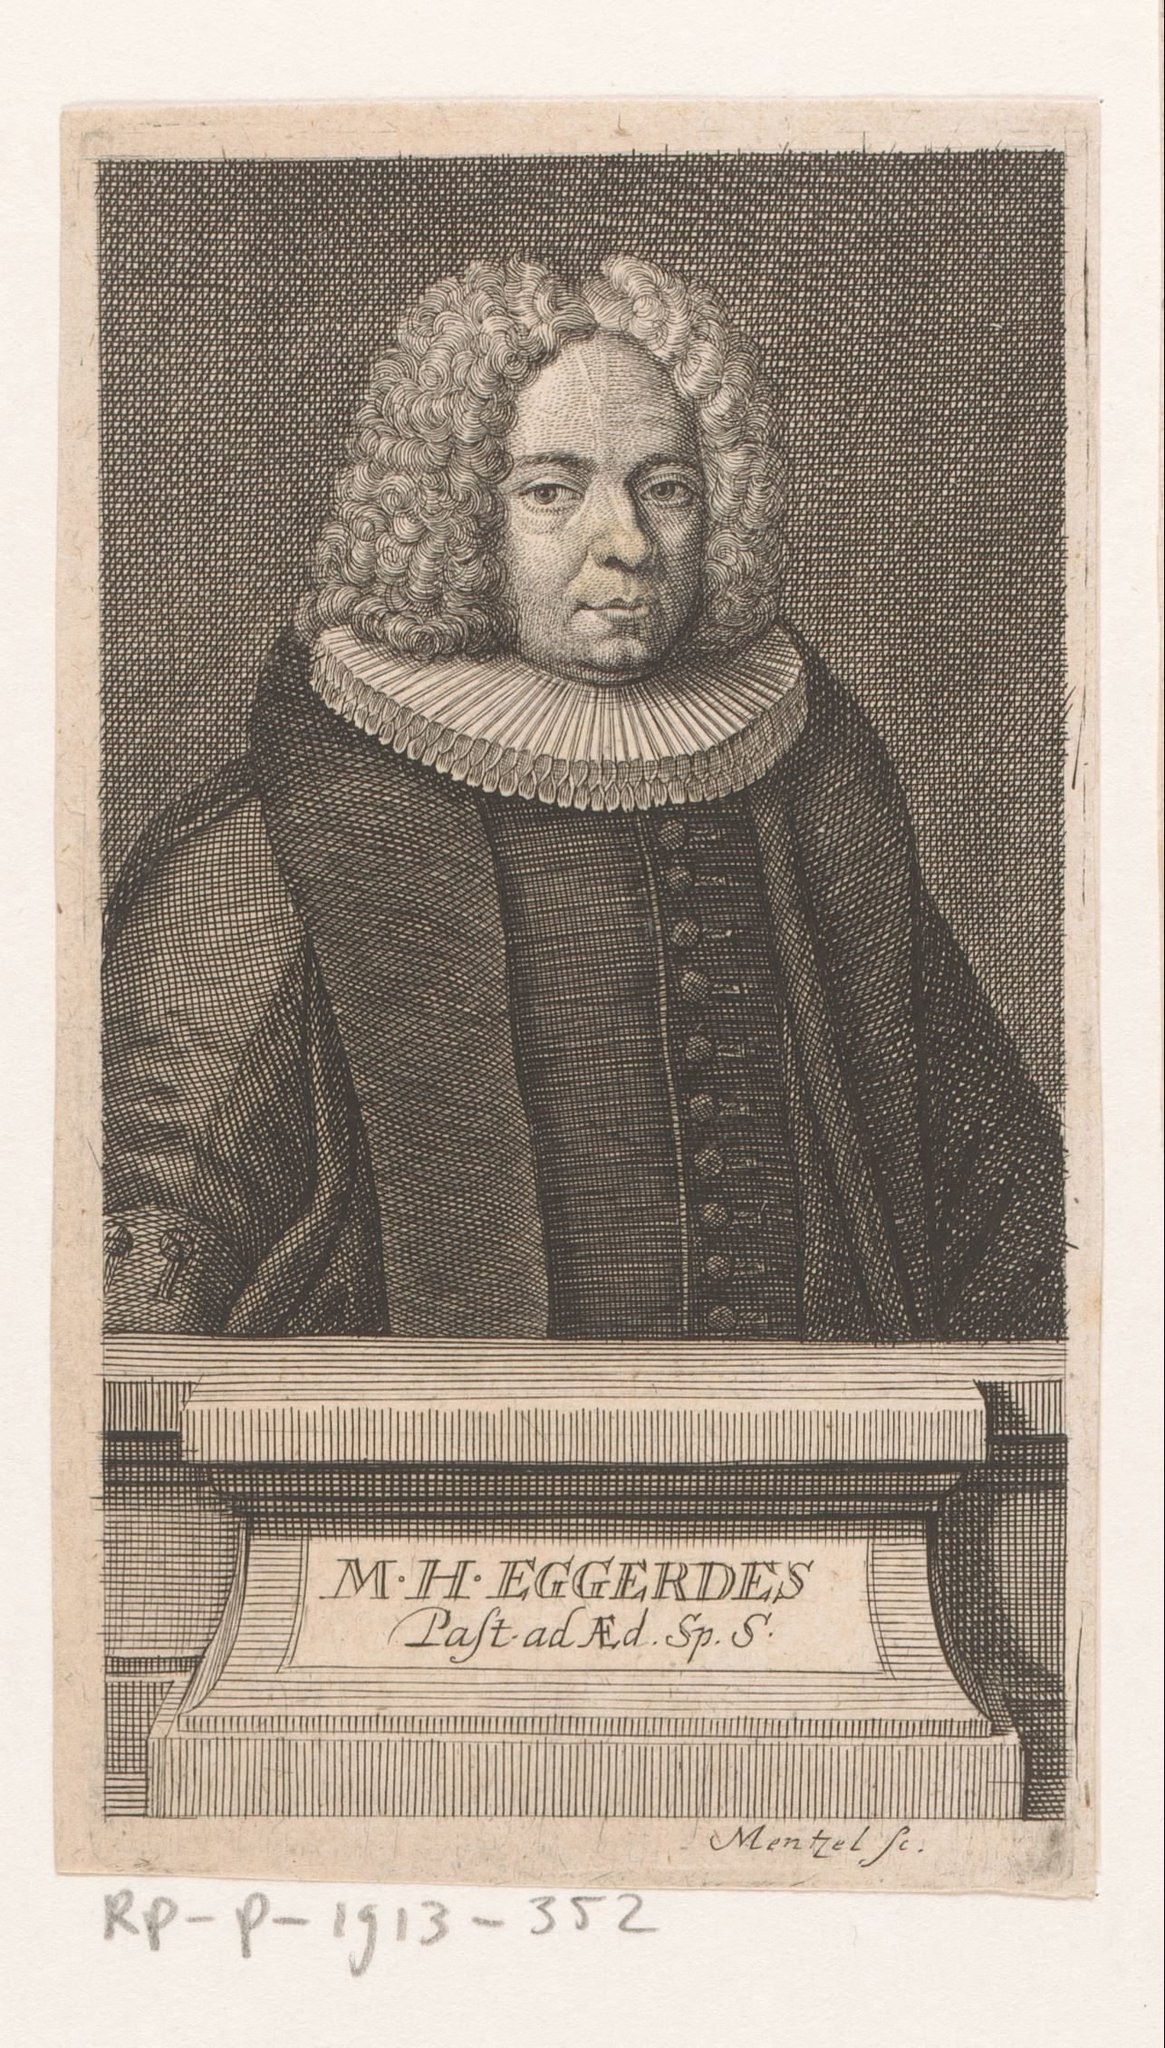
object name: print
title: Portret van Matthäus Heinrich Eggerdes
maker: johann georg mentzel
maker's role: print maker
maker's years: 1677-1743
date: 1687-1743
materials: paper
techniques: engraving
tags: theologian, historical persons, wig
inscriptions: collector's mark: Lugt 2228